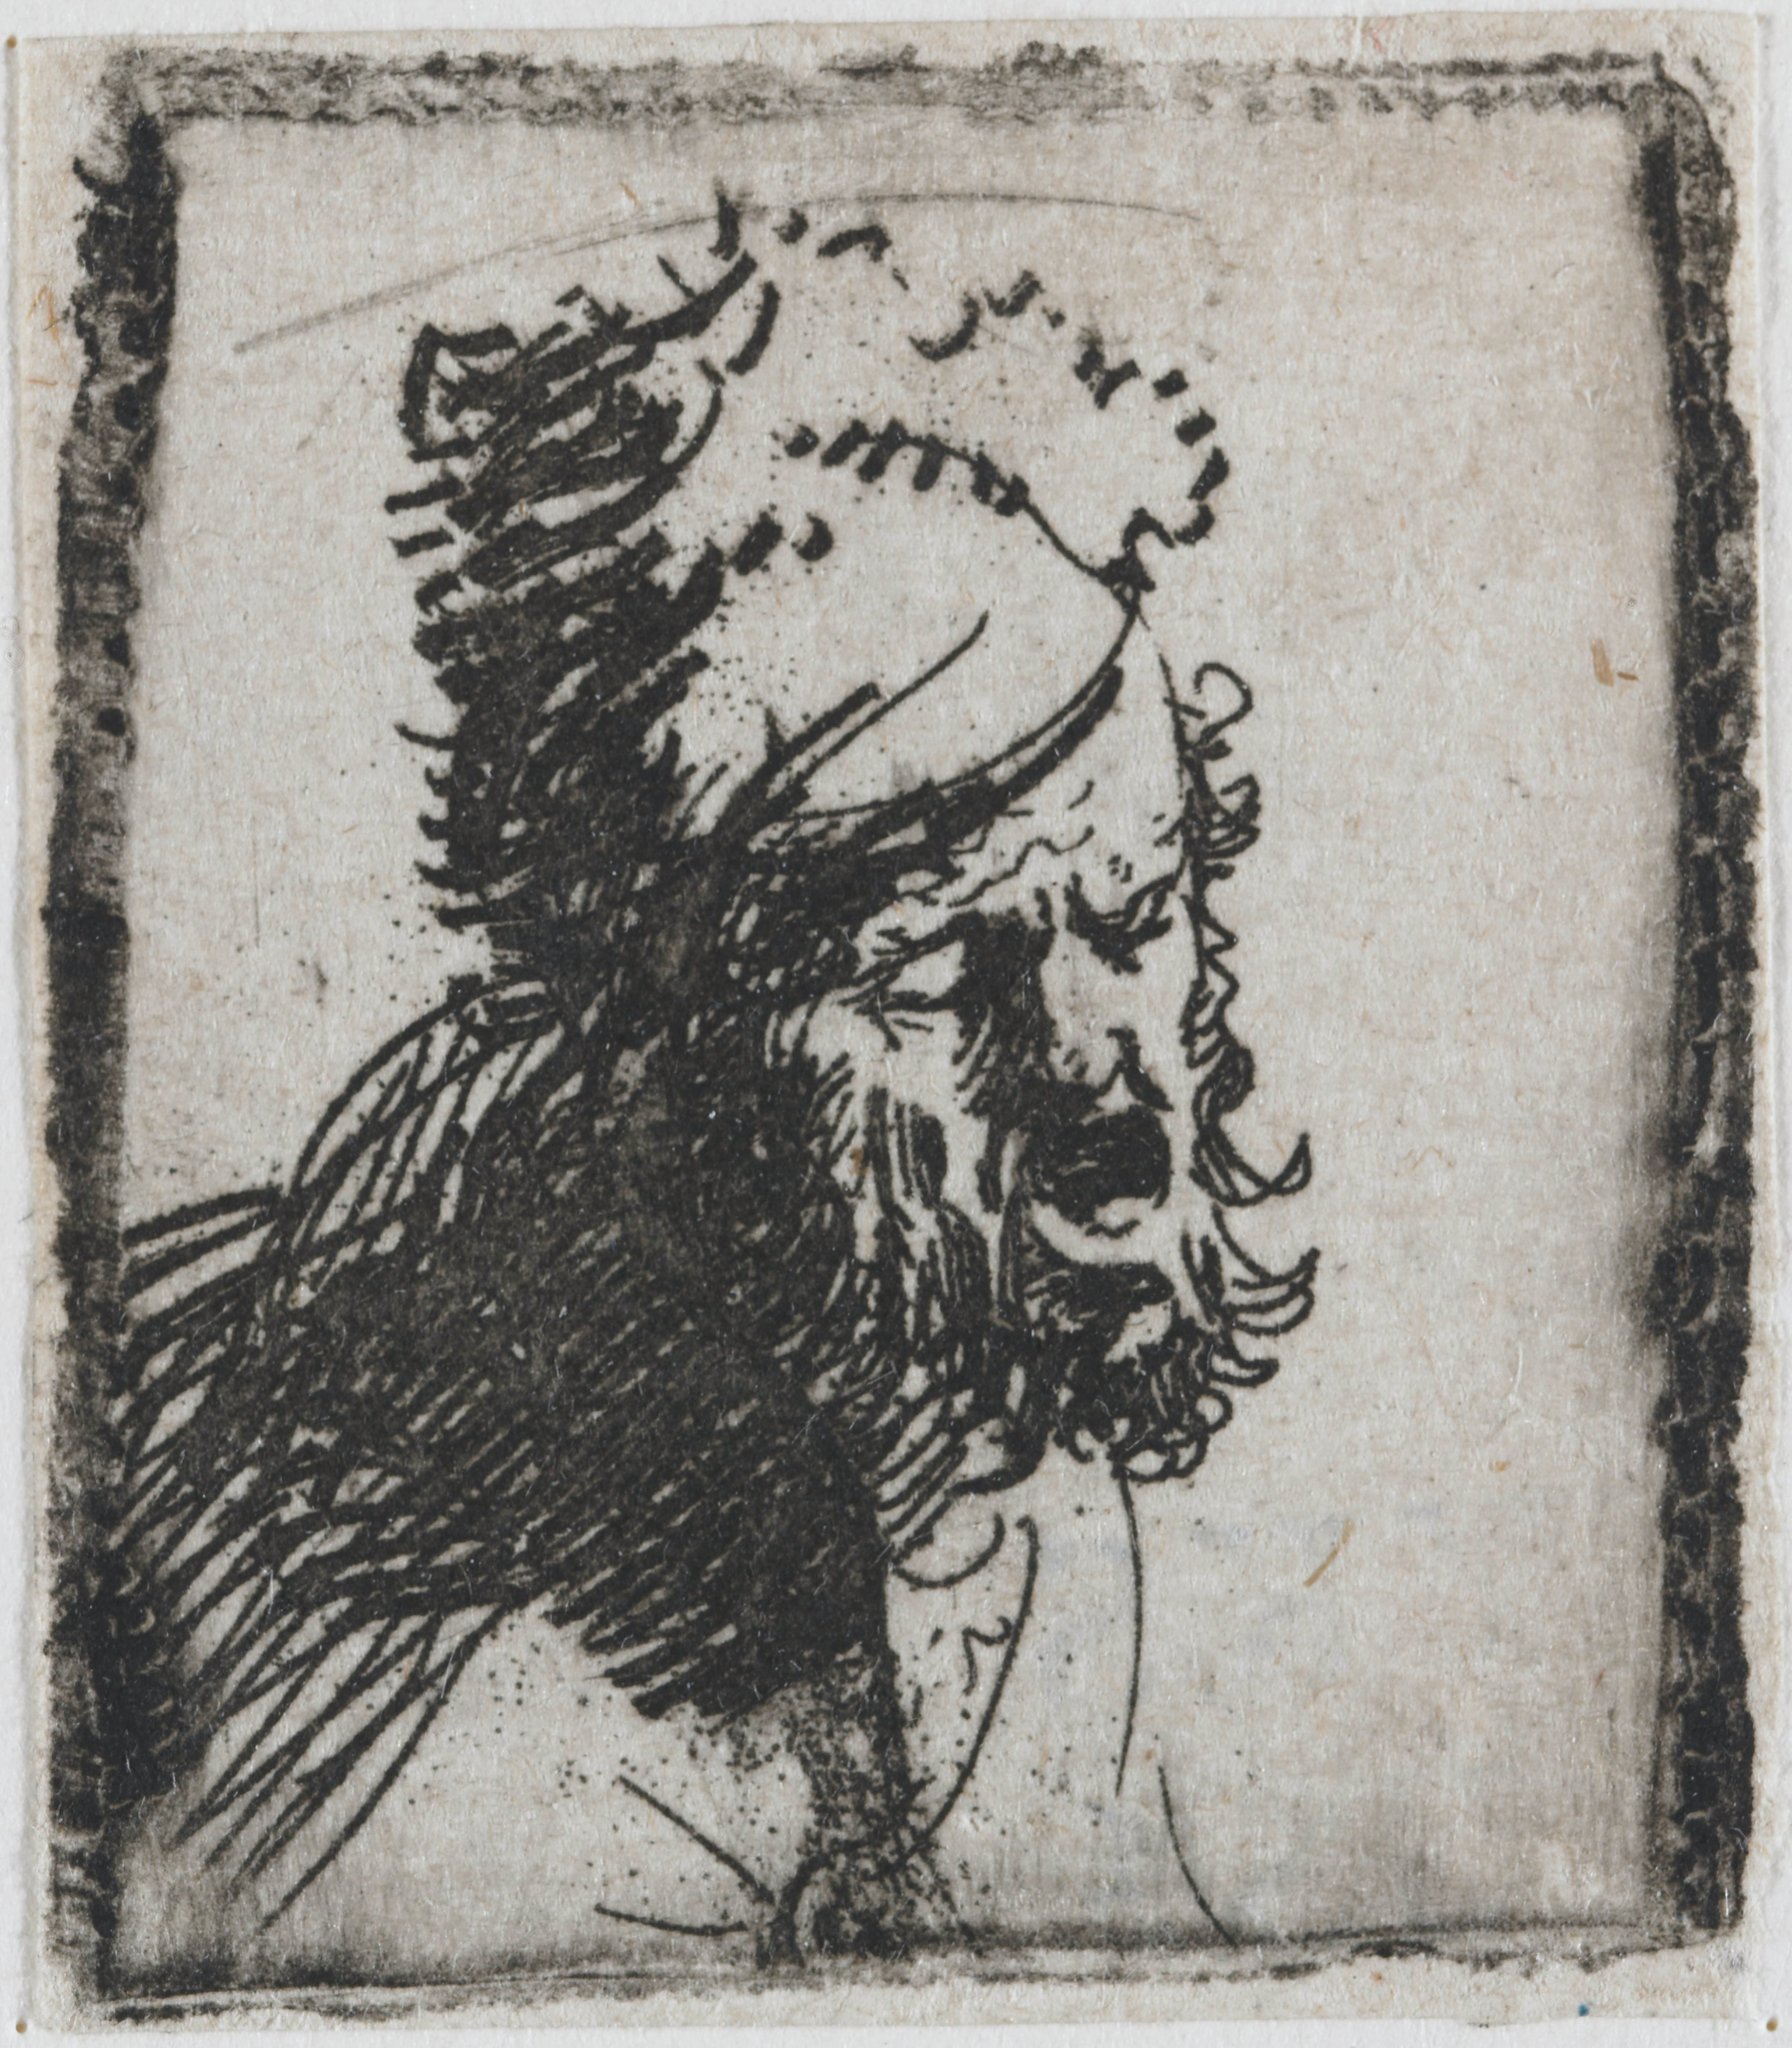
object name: print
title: Head of a Man in a Fur Cap, Crying Out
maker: rembrandt van rijn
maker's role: draughtsman, painter, print maker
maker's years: 1606-1669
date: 1629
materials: paper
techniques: etching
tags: head-gear (with name)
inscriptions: collector's mark: Lugt 2165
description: A striking feature of these four prints is how small they are. Rembrandt must have found it difficult to hold the little copperplates to draw the composition in the etching ground. He is fascinated by the quirky hats. Some are so tall they beg the question whether he depicted them faithfully or somewhat exaggerated their height.